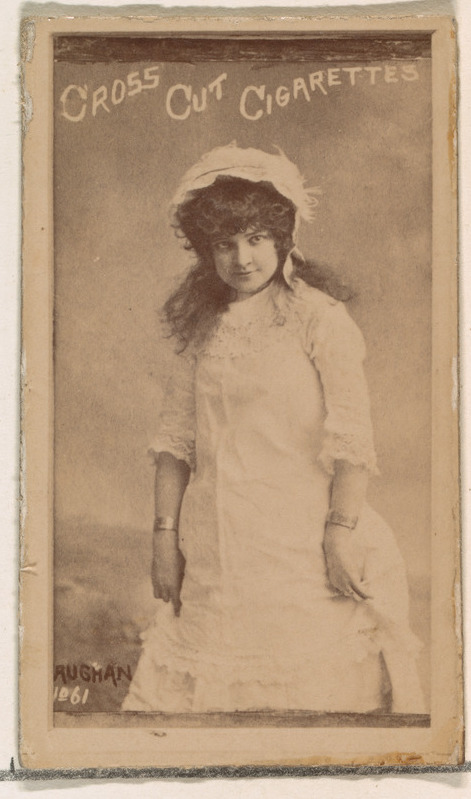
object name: print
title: Card Number 61, Rughan, from the Actors and Actresses series (N145-1) issued by Duke Sons & Co. to promote Cross Cut Cigarettes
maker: w. duke, sons & co.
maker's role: publisher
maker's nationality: american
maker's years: 1870-1920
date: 1880-1889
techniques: albumen silver print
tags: portraits,women,actresses